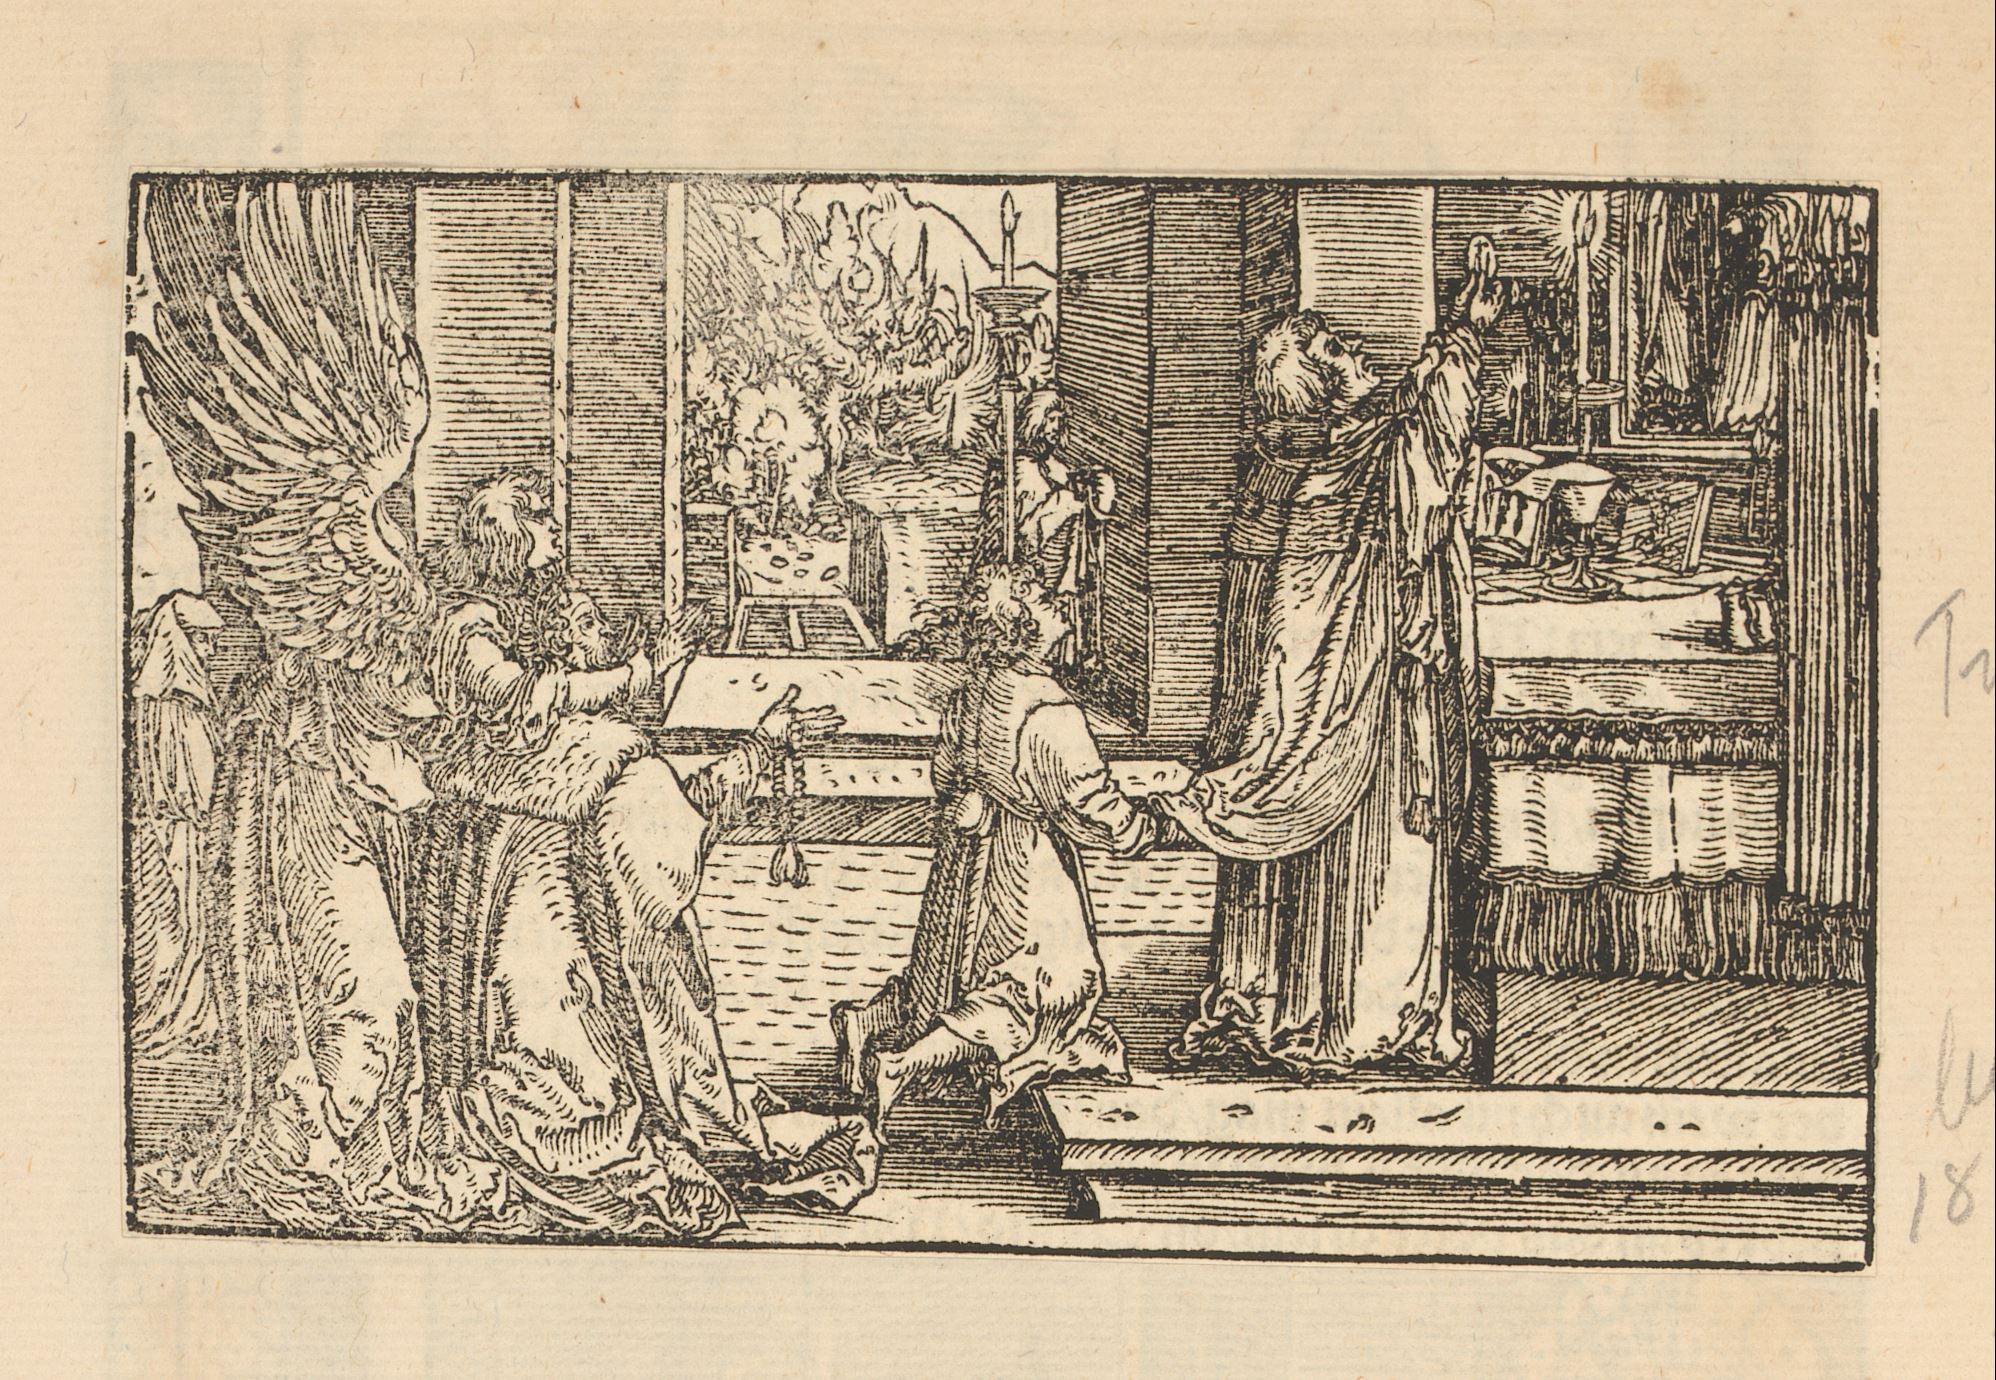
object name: album leaf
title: Engel en knielende monnik bidden bij het altaar waar een priester de hostie wijdt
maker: Anonymous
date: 1514-1532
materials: paper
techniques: letterpress printing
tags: bread, host, public worship and liturgy of the christian churches, angels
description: Deze prent is gebruikt in: Petrarca, Francesco. Von der Artzney bayder Glück, des guten und widerwertigen: unnd weß sich ain yeder inn Gelück und Unglück halten sol (...). Augsburg: Heinrich Steiner, 1532. Deze uitgave is ook bekend onder de titel 'Trostspiegel in Glück und Unglück'.